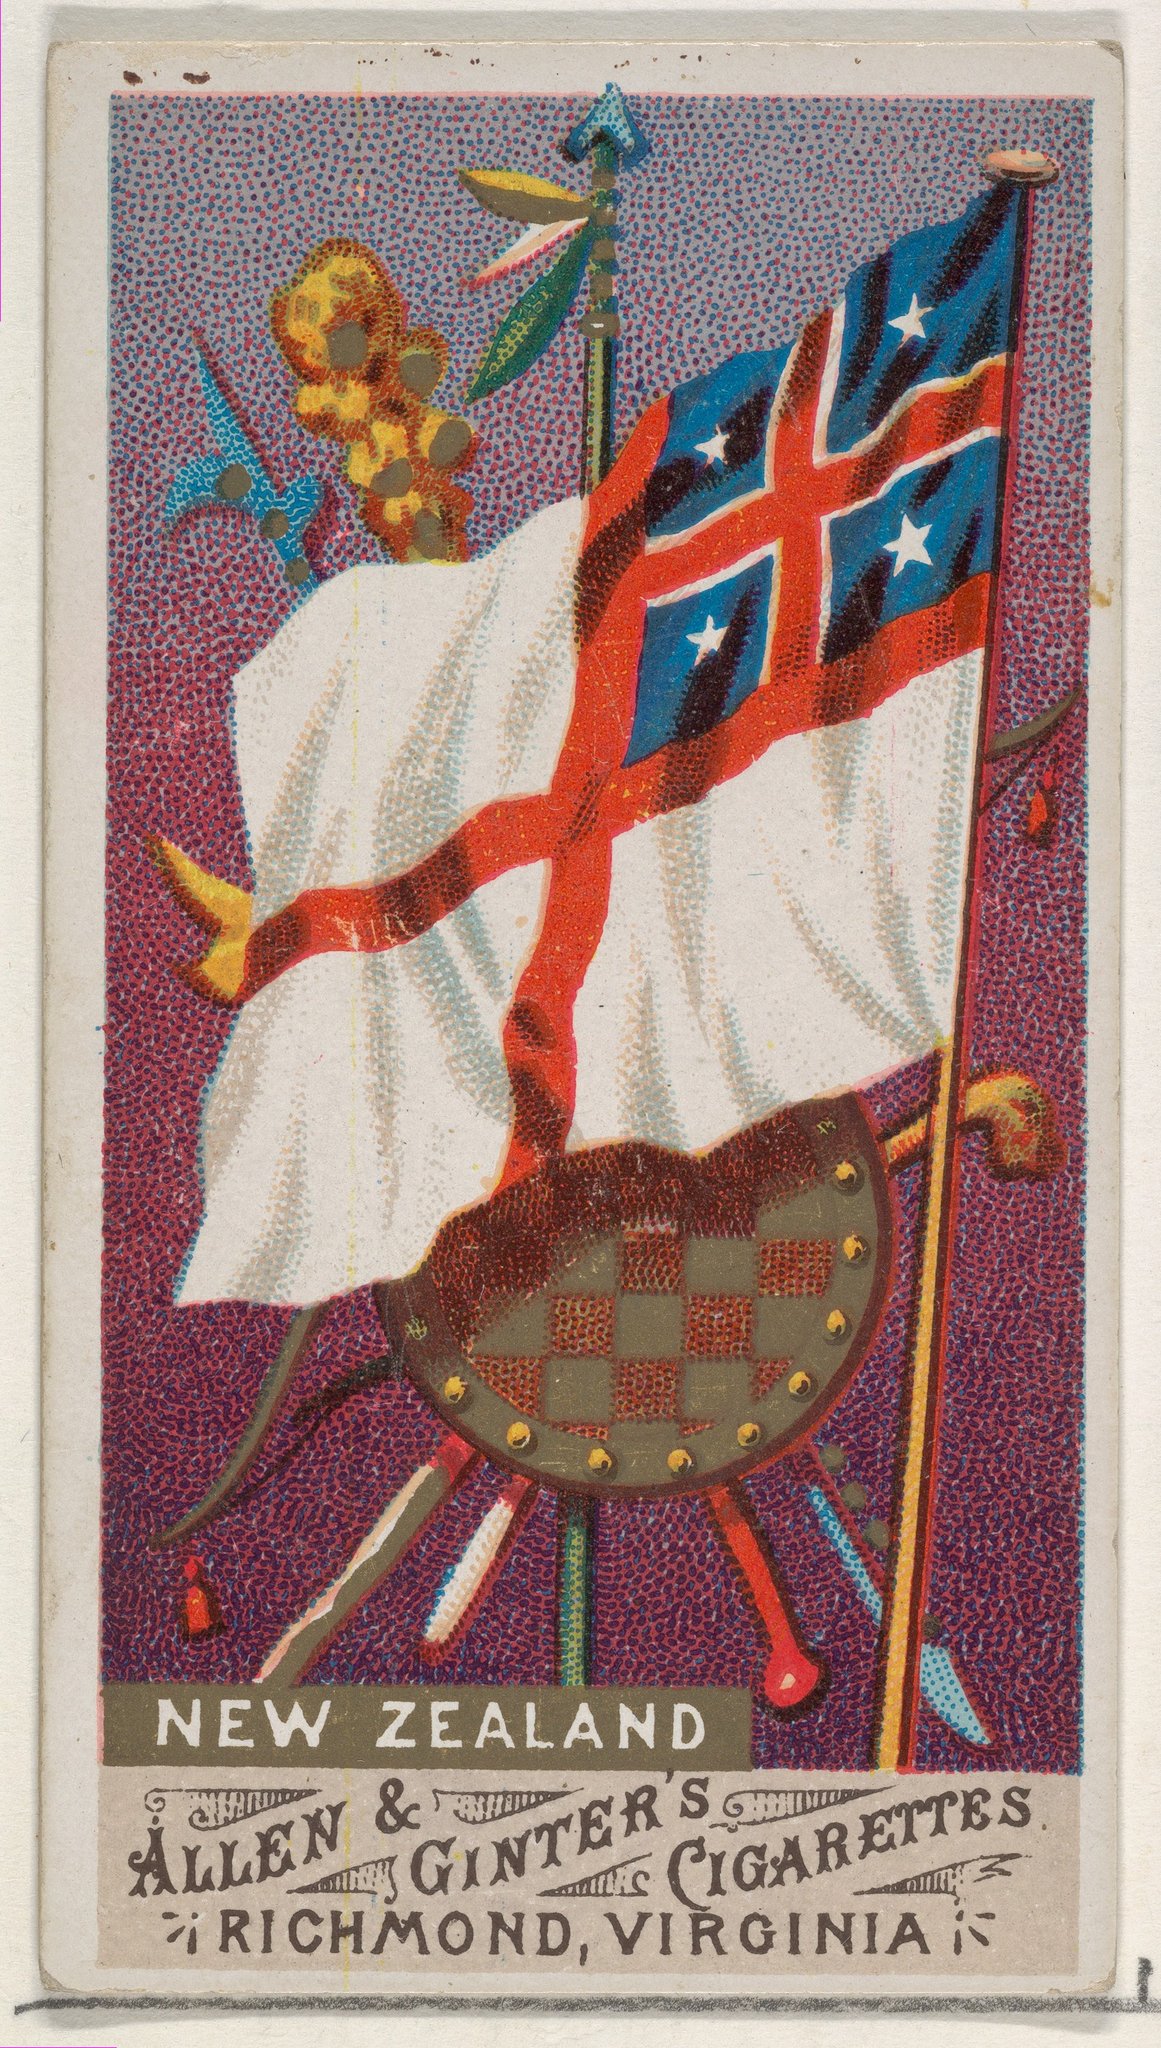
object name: print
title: New Zealand, from Flags of All Nations, Series 1 (N9) for Allen & Ginter Cigarettes Brands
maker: allen & ginter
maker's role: publisher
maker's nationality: american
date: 1887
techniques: color lithograph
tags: flags